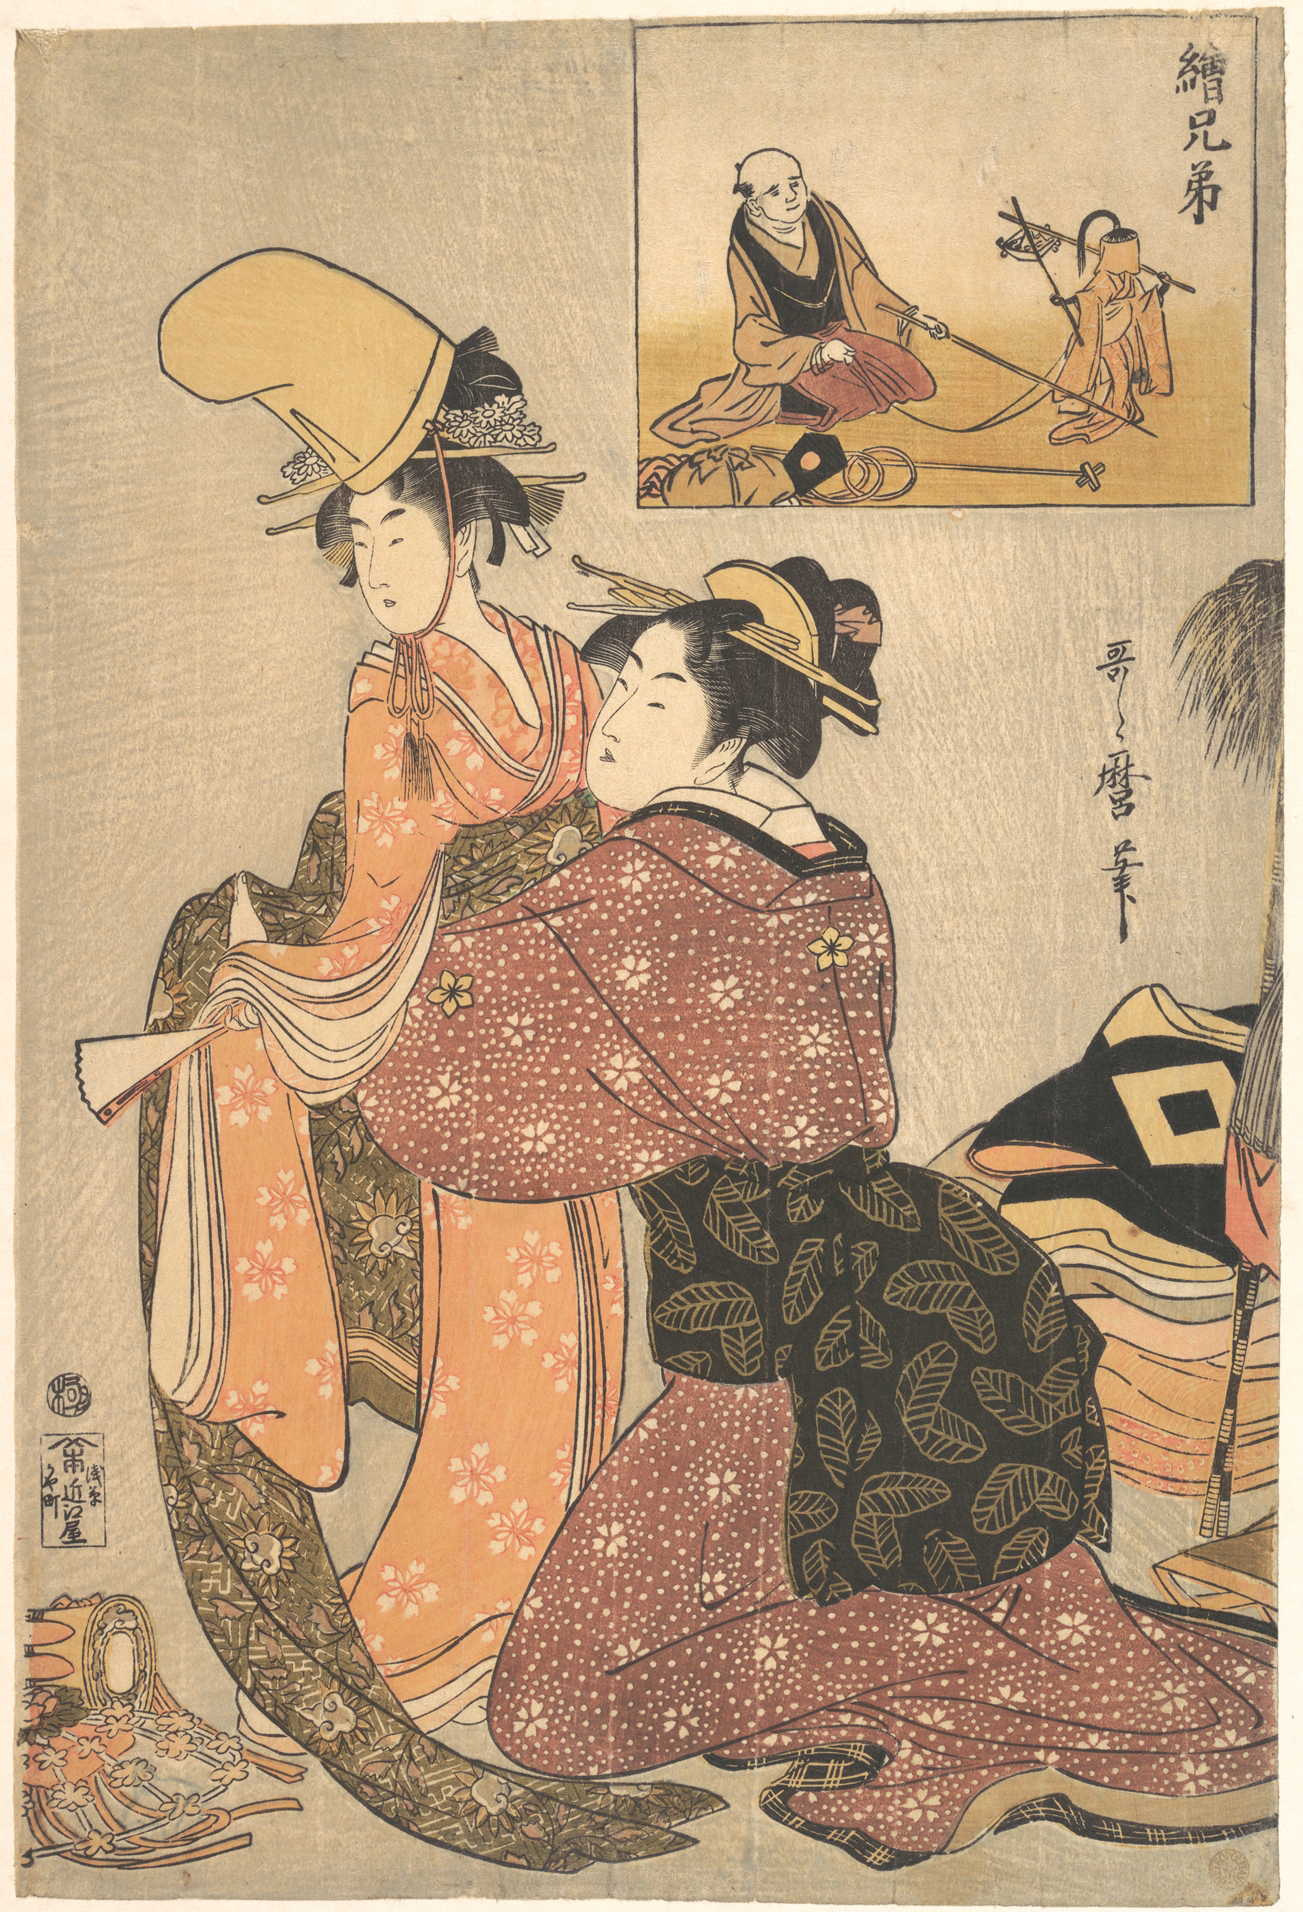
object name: print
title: A Woman Dressing a Girl for a the Kabuki Dance “Musume Dojōji,” with “Brother Picture” (E-kyōdai) of a Monkey Trainer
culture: japanese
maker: kitagawa utamaro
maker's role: artist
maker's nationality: japanese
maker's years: 1754-1806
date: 1795-1796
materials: ink, paper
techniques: woodblock print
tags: men,women,dressing